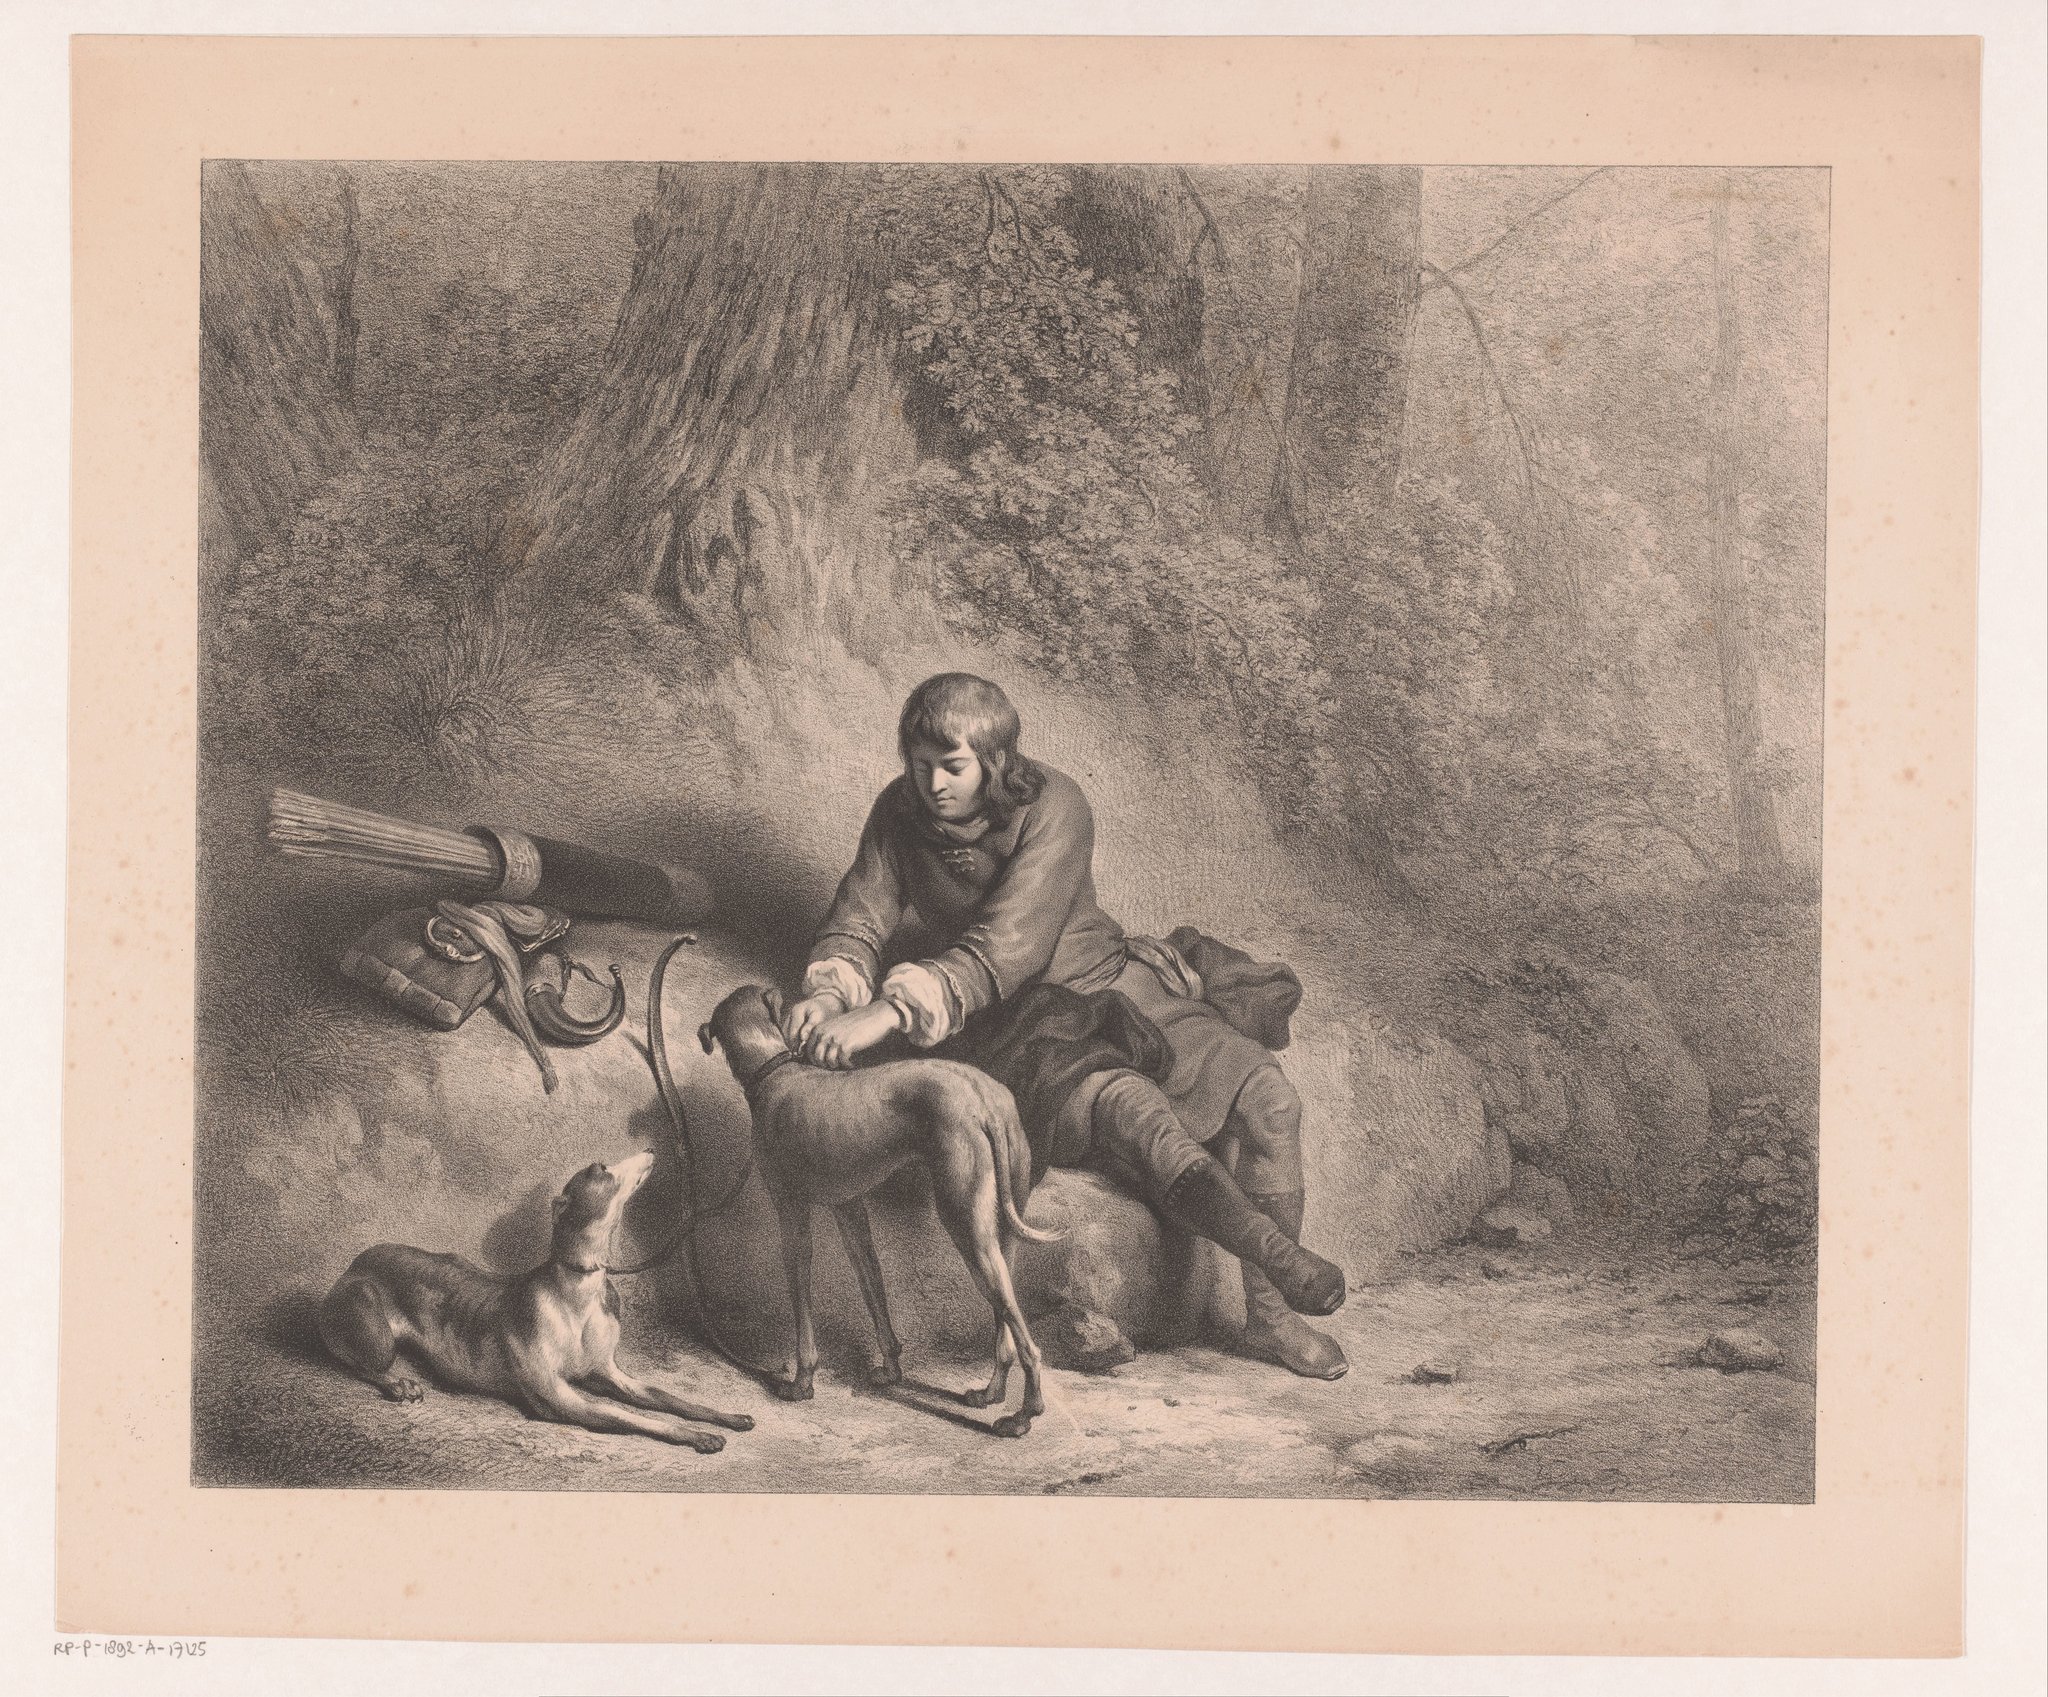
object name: print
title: Jager maakt zich klaar voor de jacht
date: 1820-1833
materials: paper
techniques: lithograph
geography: amsterdam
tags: archer's weapons: bow and arrow, hunting dogs, hunter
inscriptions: collector's mark: Lugt 2228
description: De jager maakt de riem los van een van zijn twee honden. Naast hem liggen zijn jachthoorn, pijlen en boog.